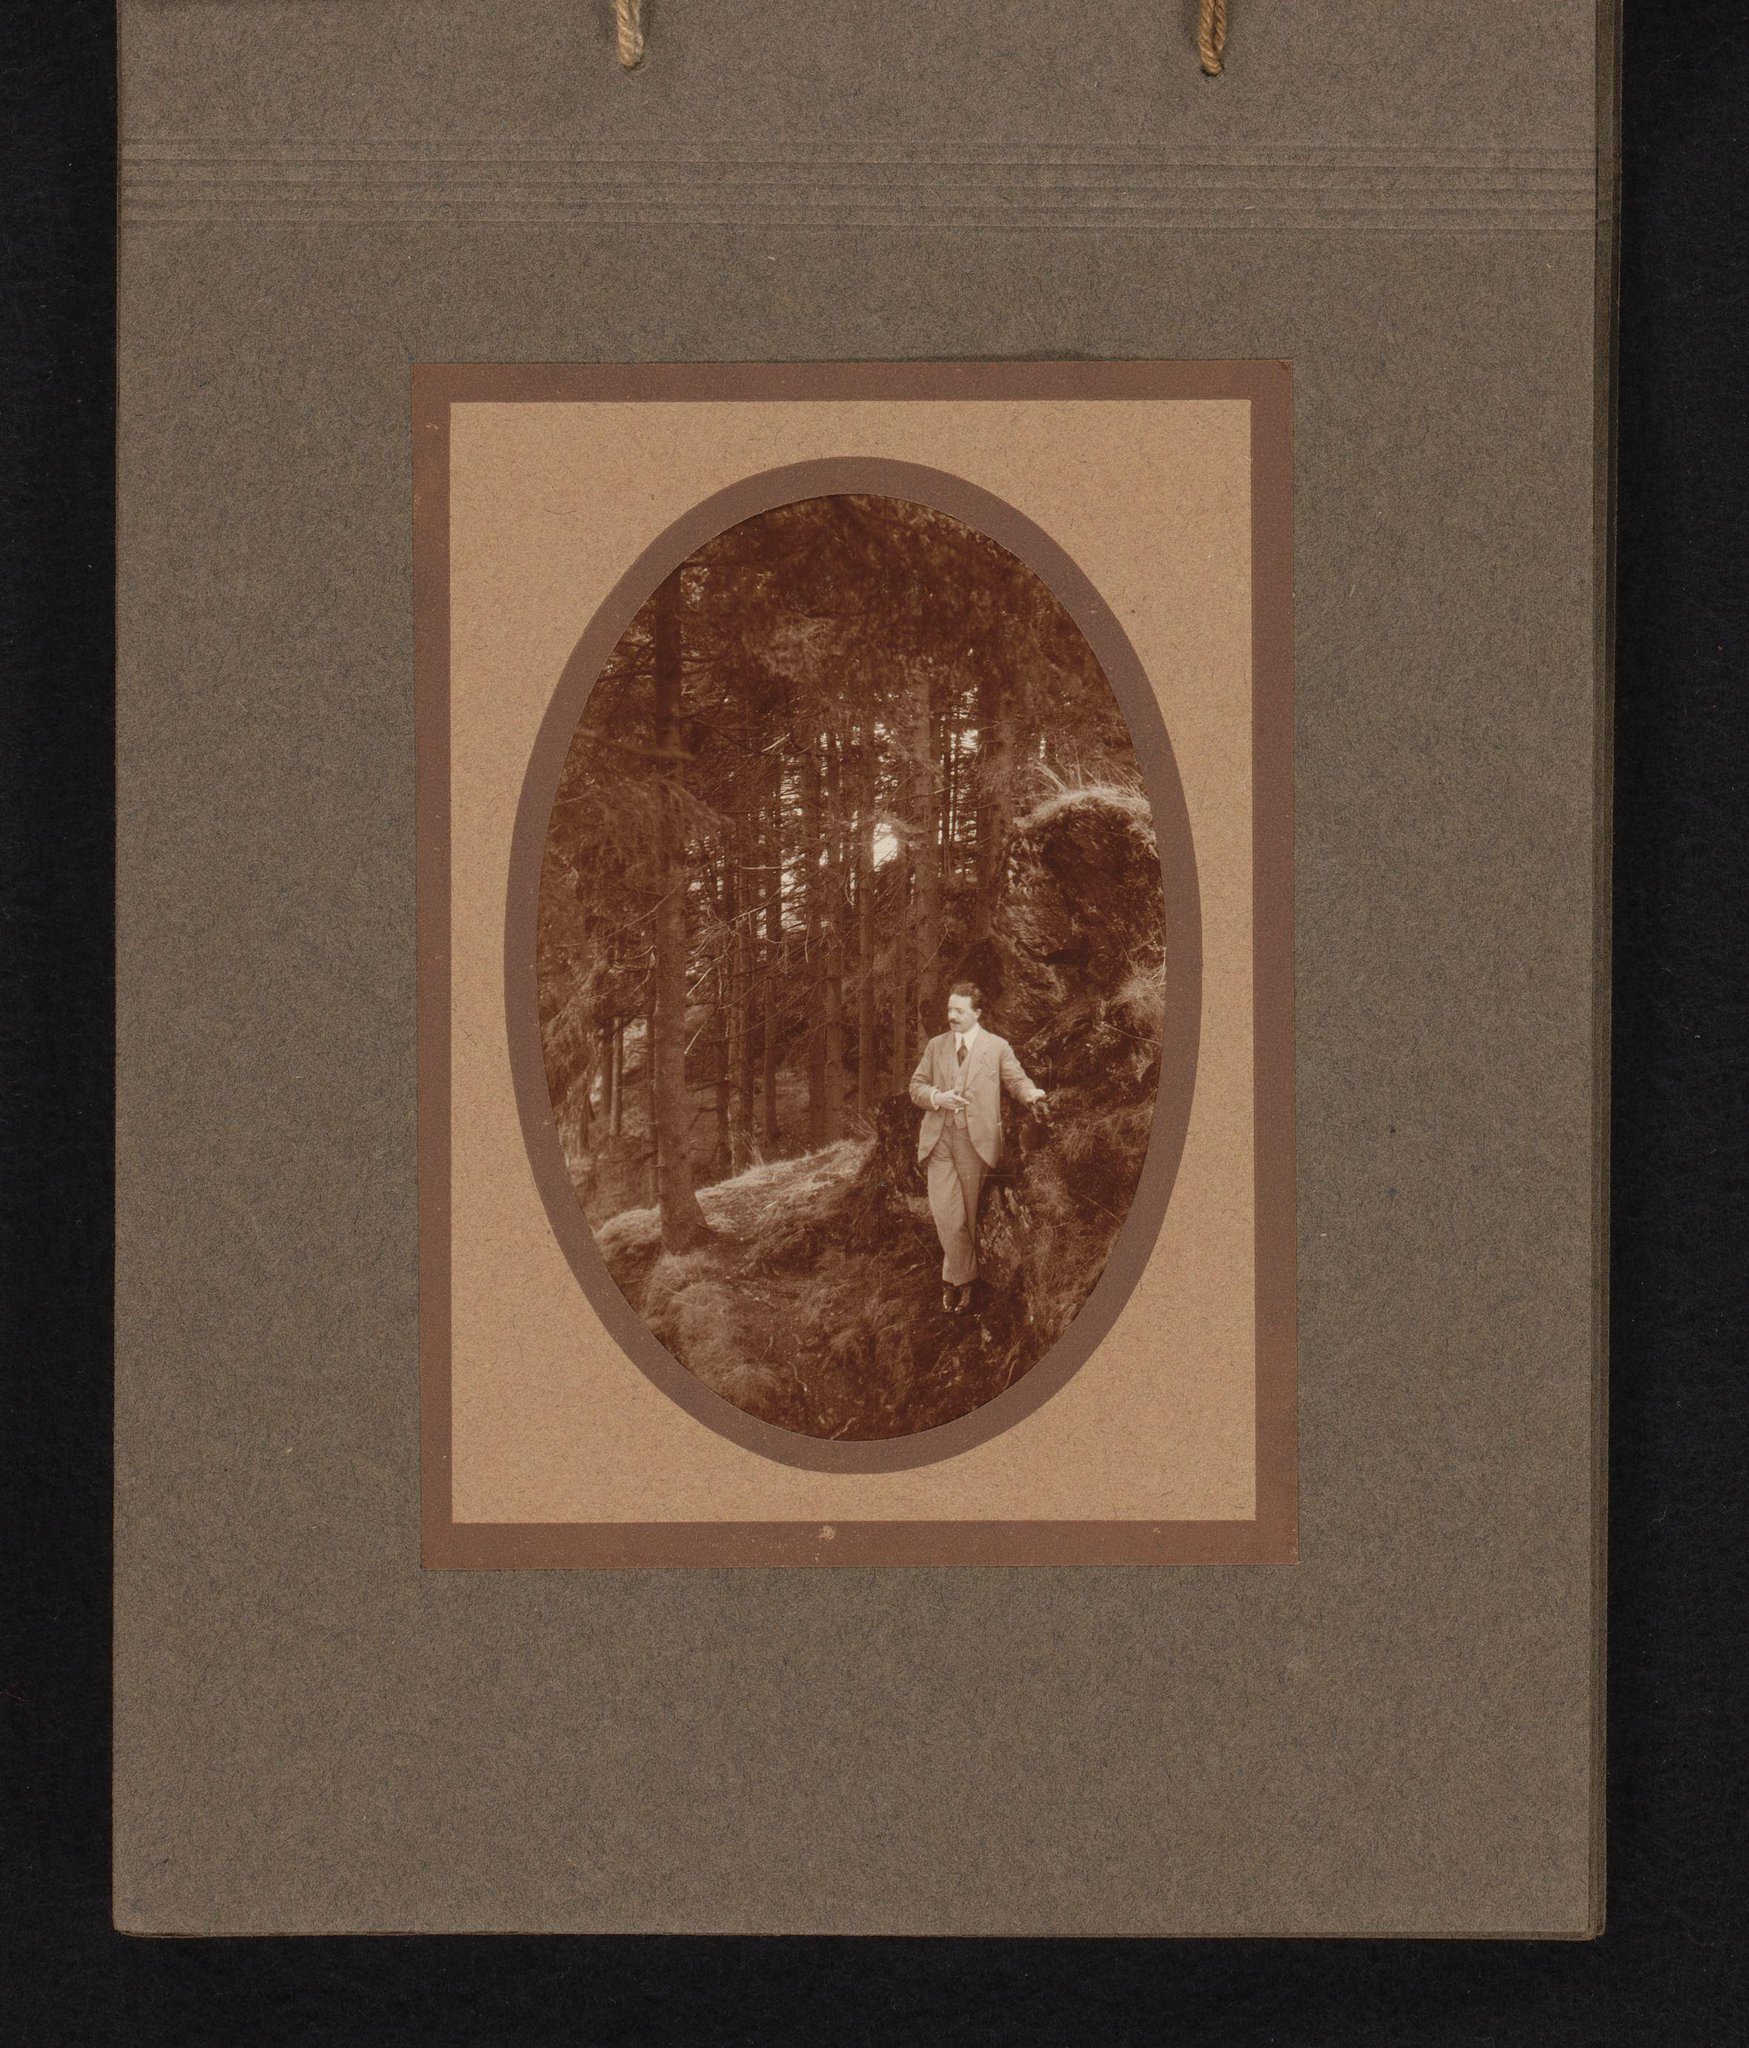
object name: photograph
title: Man in een bos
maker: Anonymous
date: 1880-1930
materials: cardboard, photographic support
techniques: collodion silver print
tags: trees, adult man, forest, wood